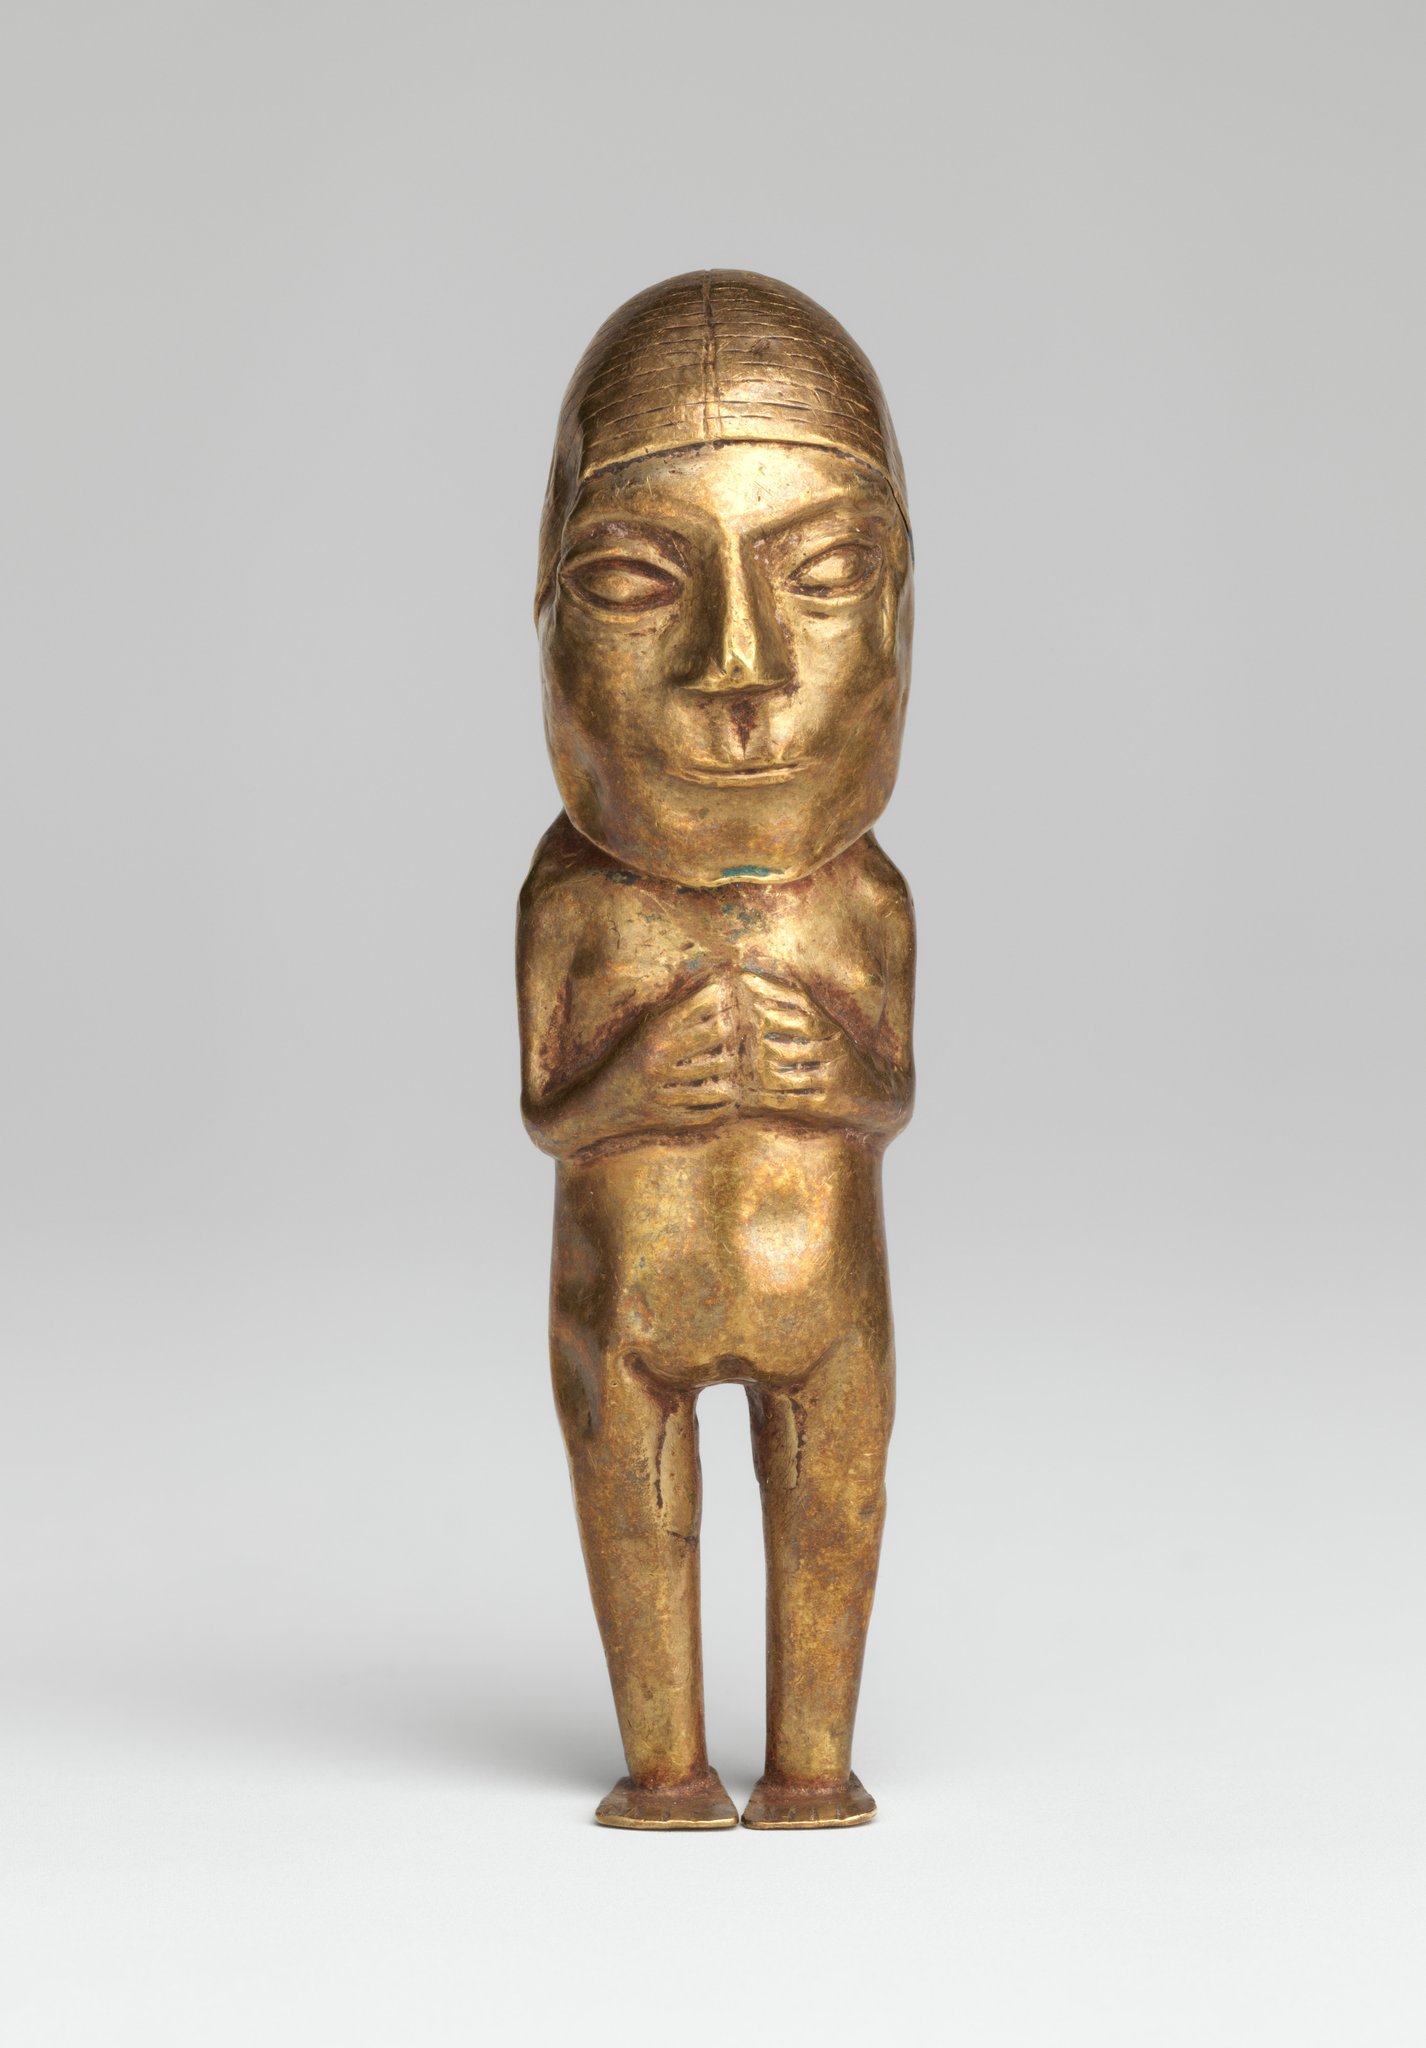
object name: figure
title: Female figurine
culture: inca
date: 1400-1533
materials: gold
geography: ecuador, peru, bolivia, chile, or argentina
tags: women